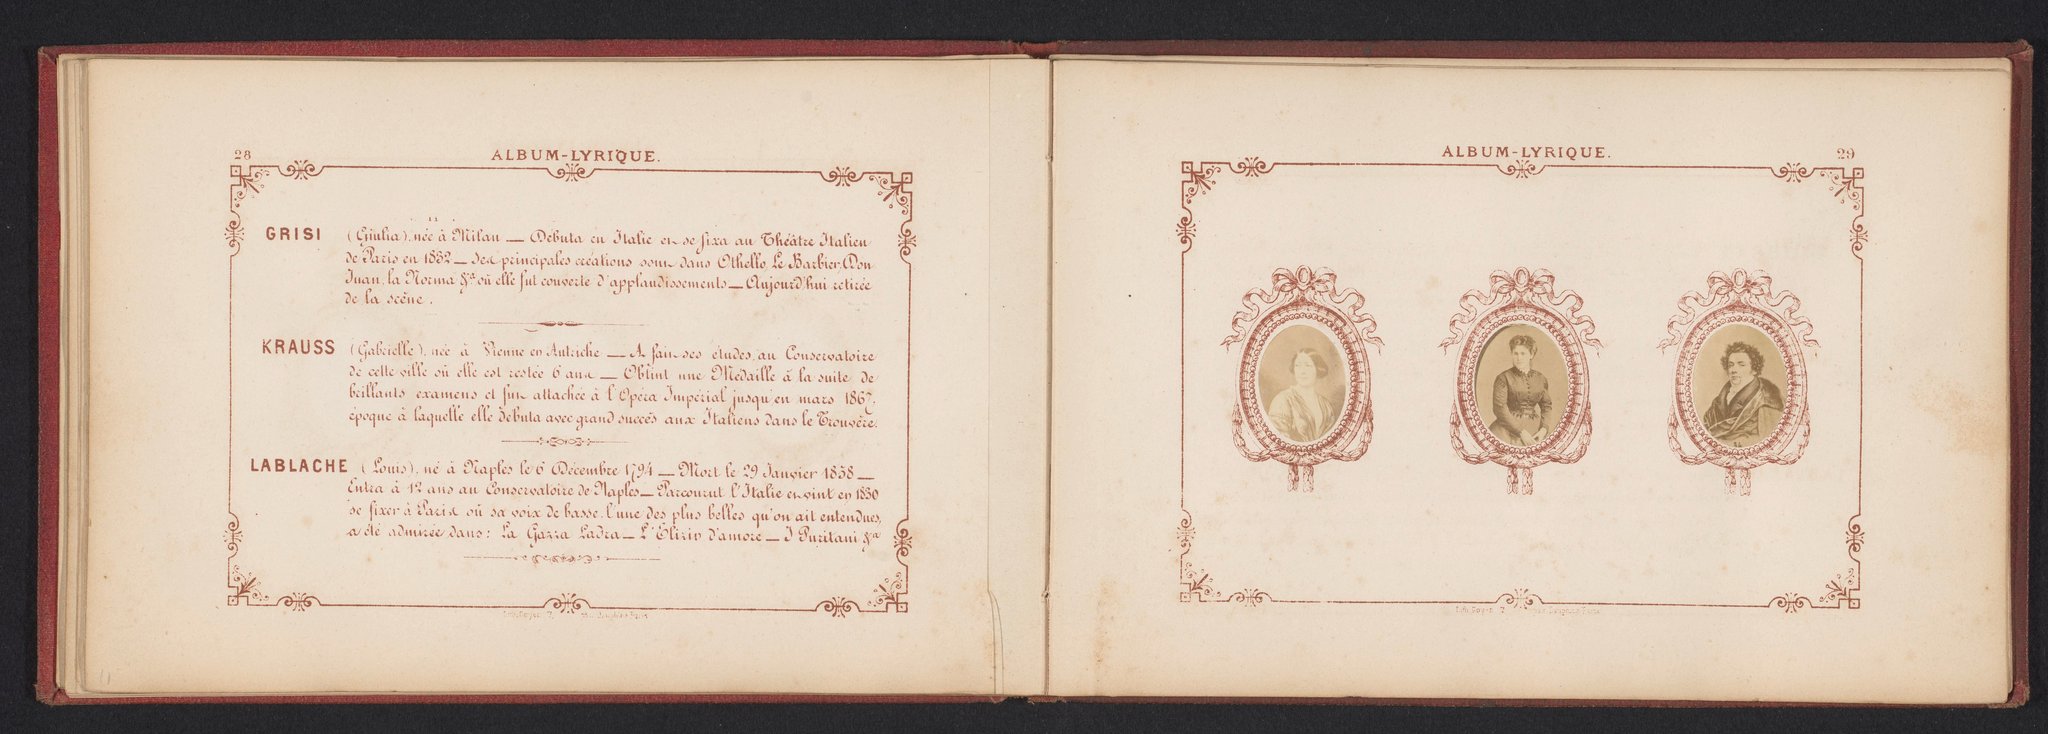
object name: page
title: Drie fotoreproducties, voorstellende portretten van Giulia Grisi, Gabrielle Krauss en Luigi Lablache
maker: antoine rené trinquart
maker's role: fotograaf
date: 1858-1868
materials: paper, photographic support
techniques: albumen print, printing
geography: france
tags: portrait of opera-singer